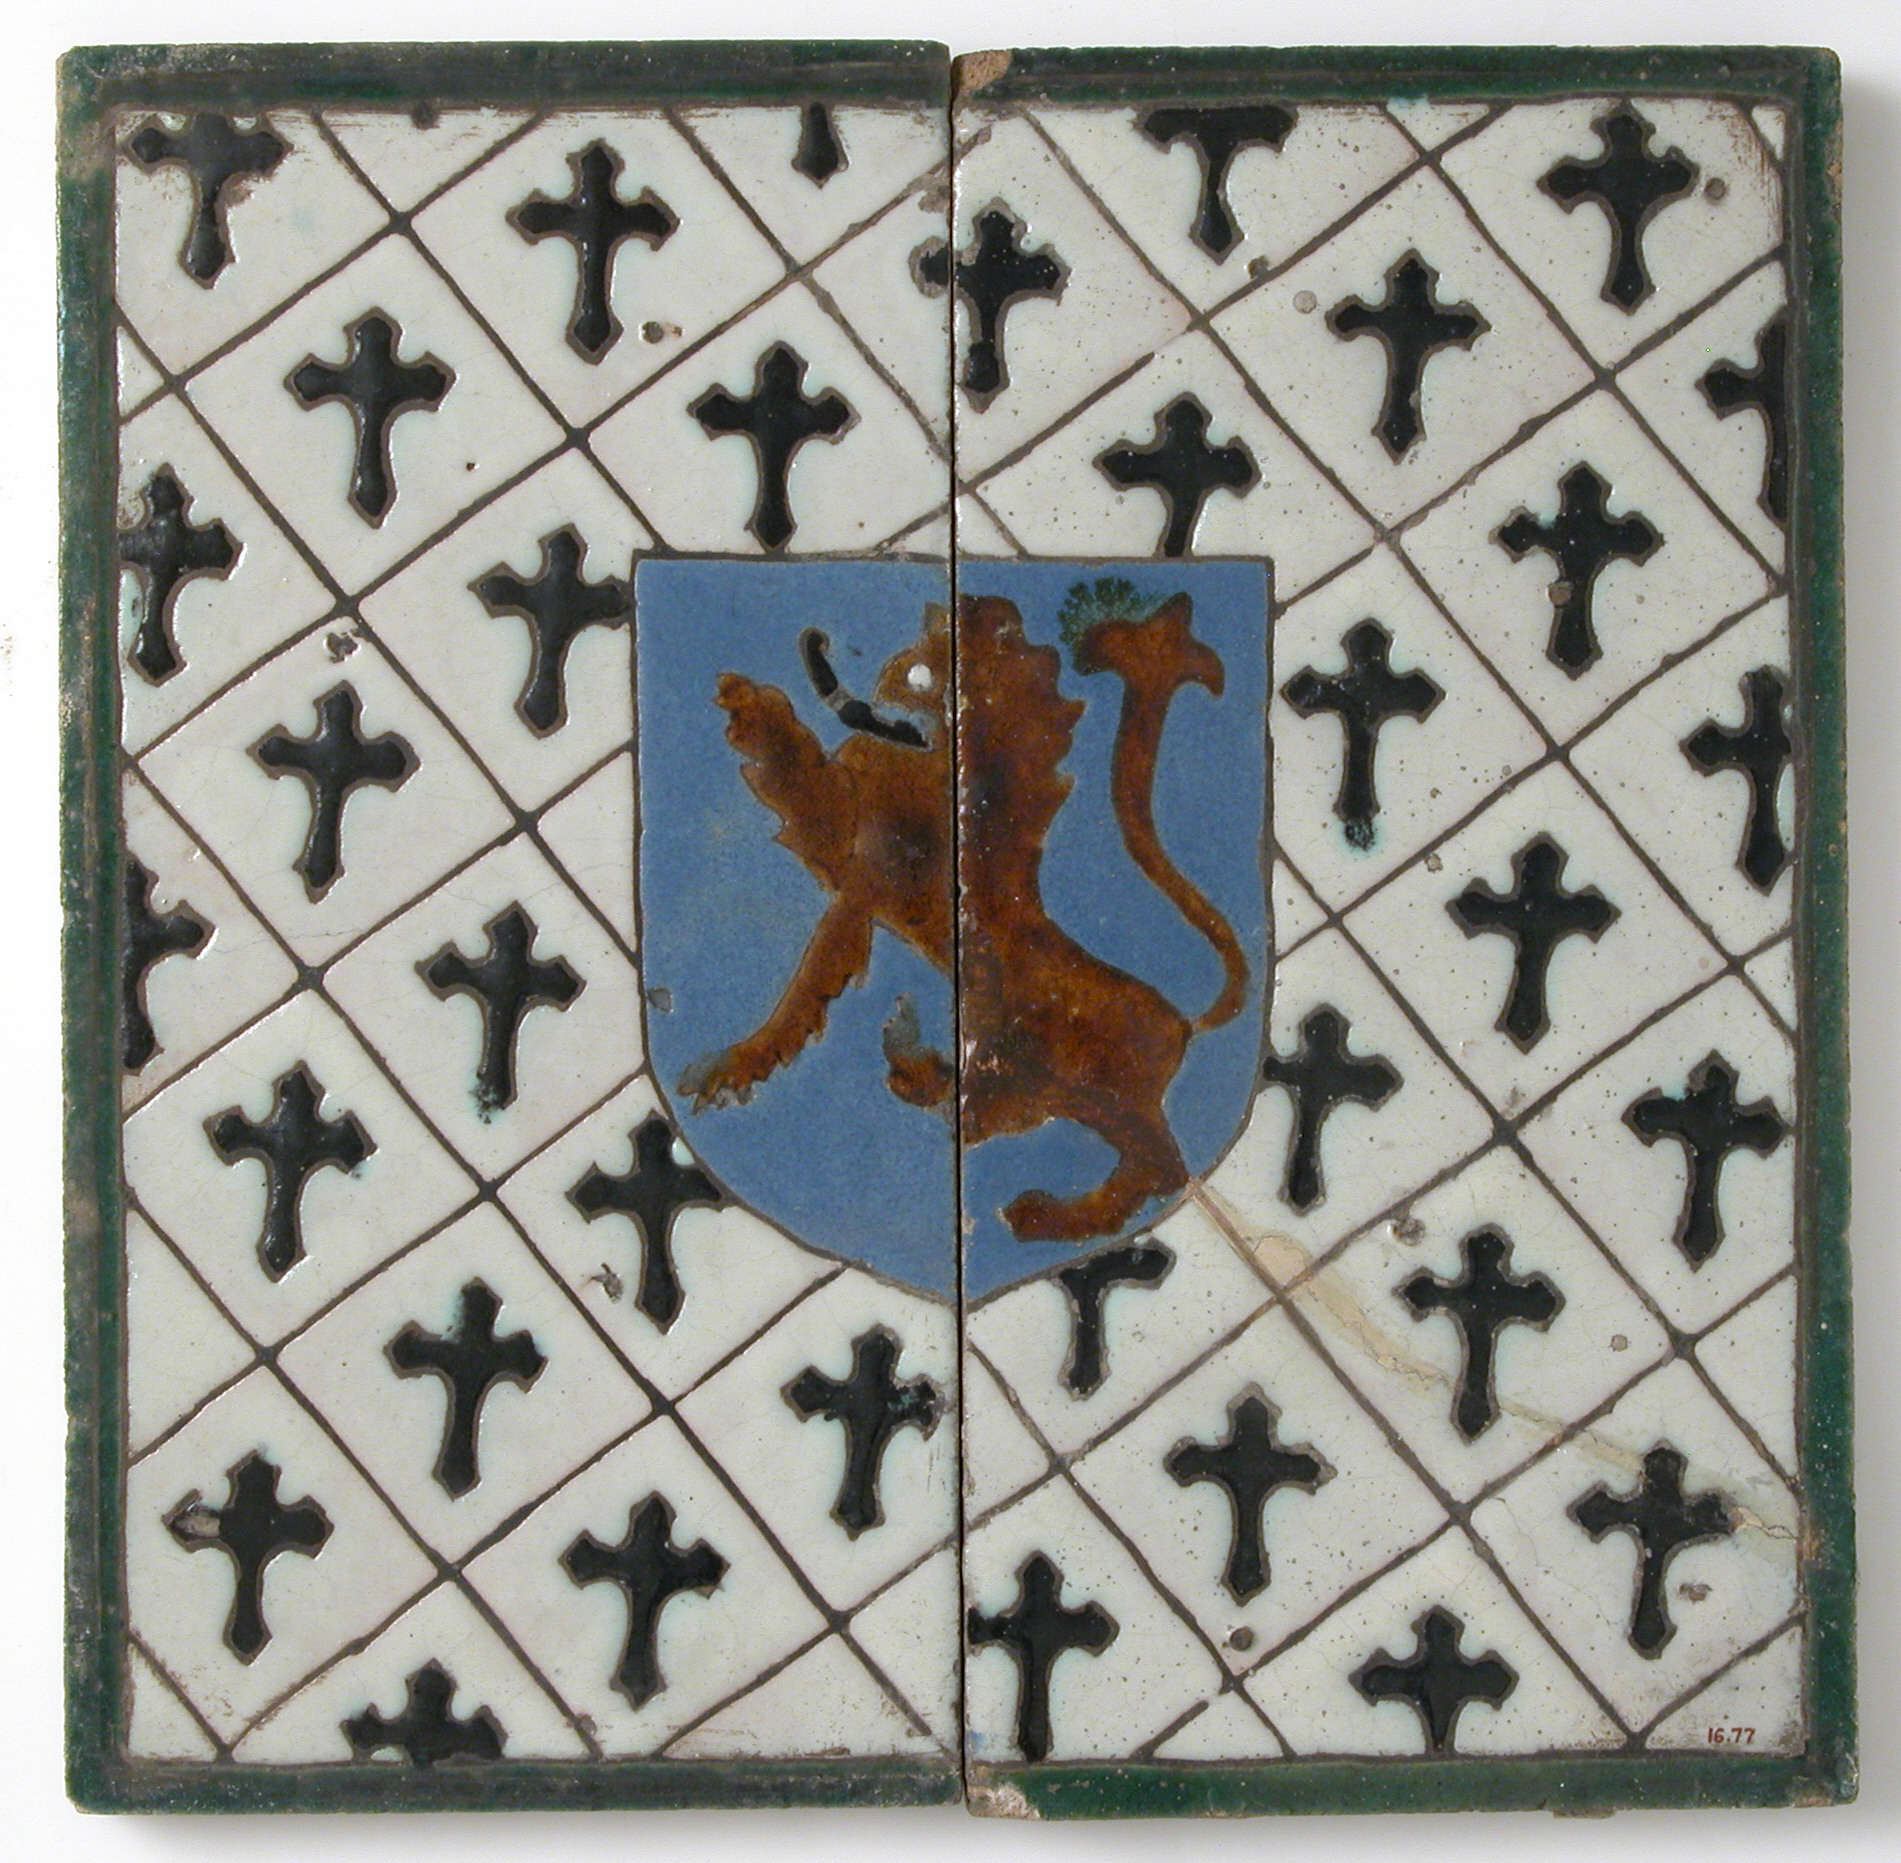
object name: tile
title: Tiles with a Lion on a Shield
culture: spanish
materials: earthenware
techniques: glazing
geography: spain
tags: lions,coat of arms